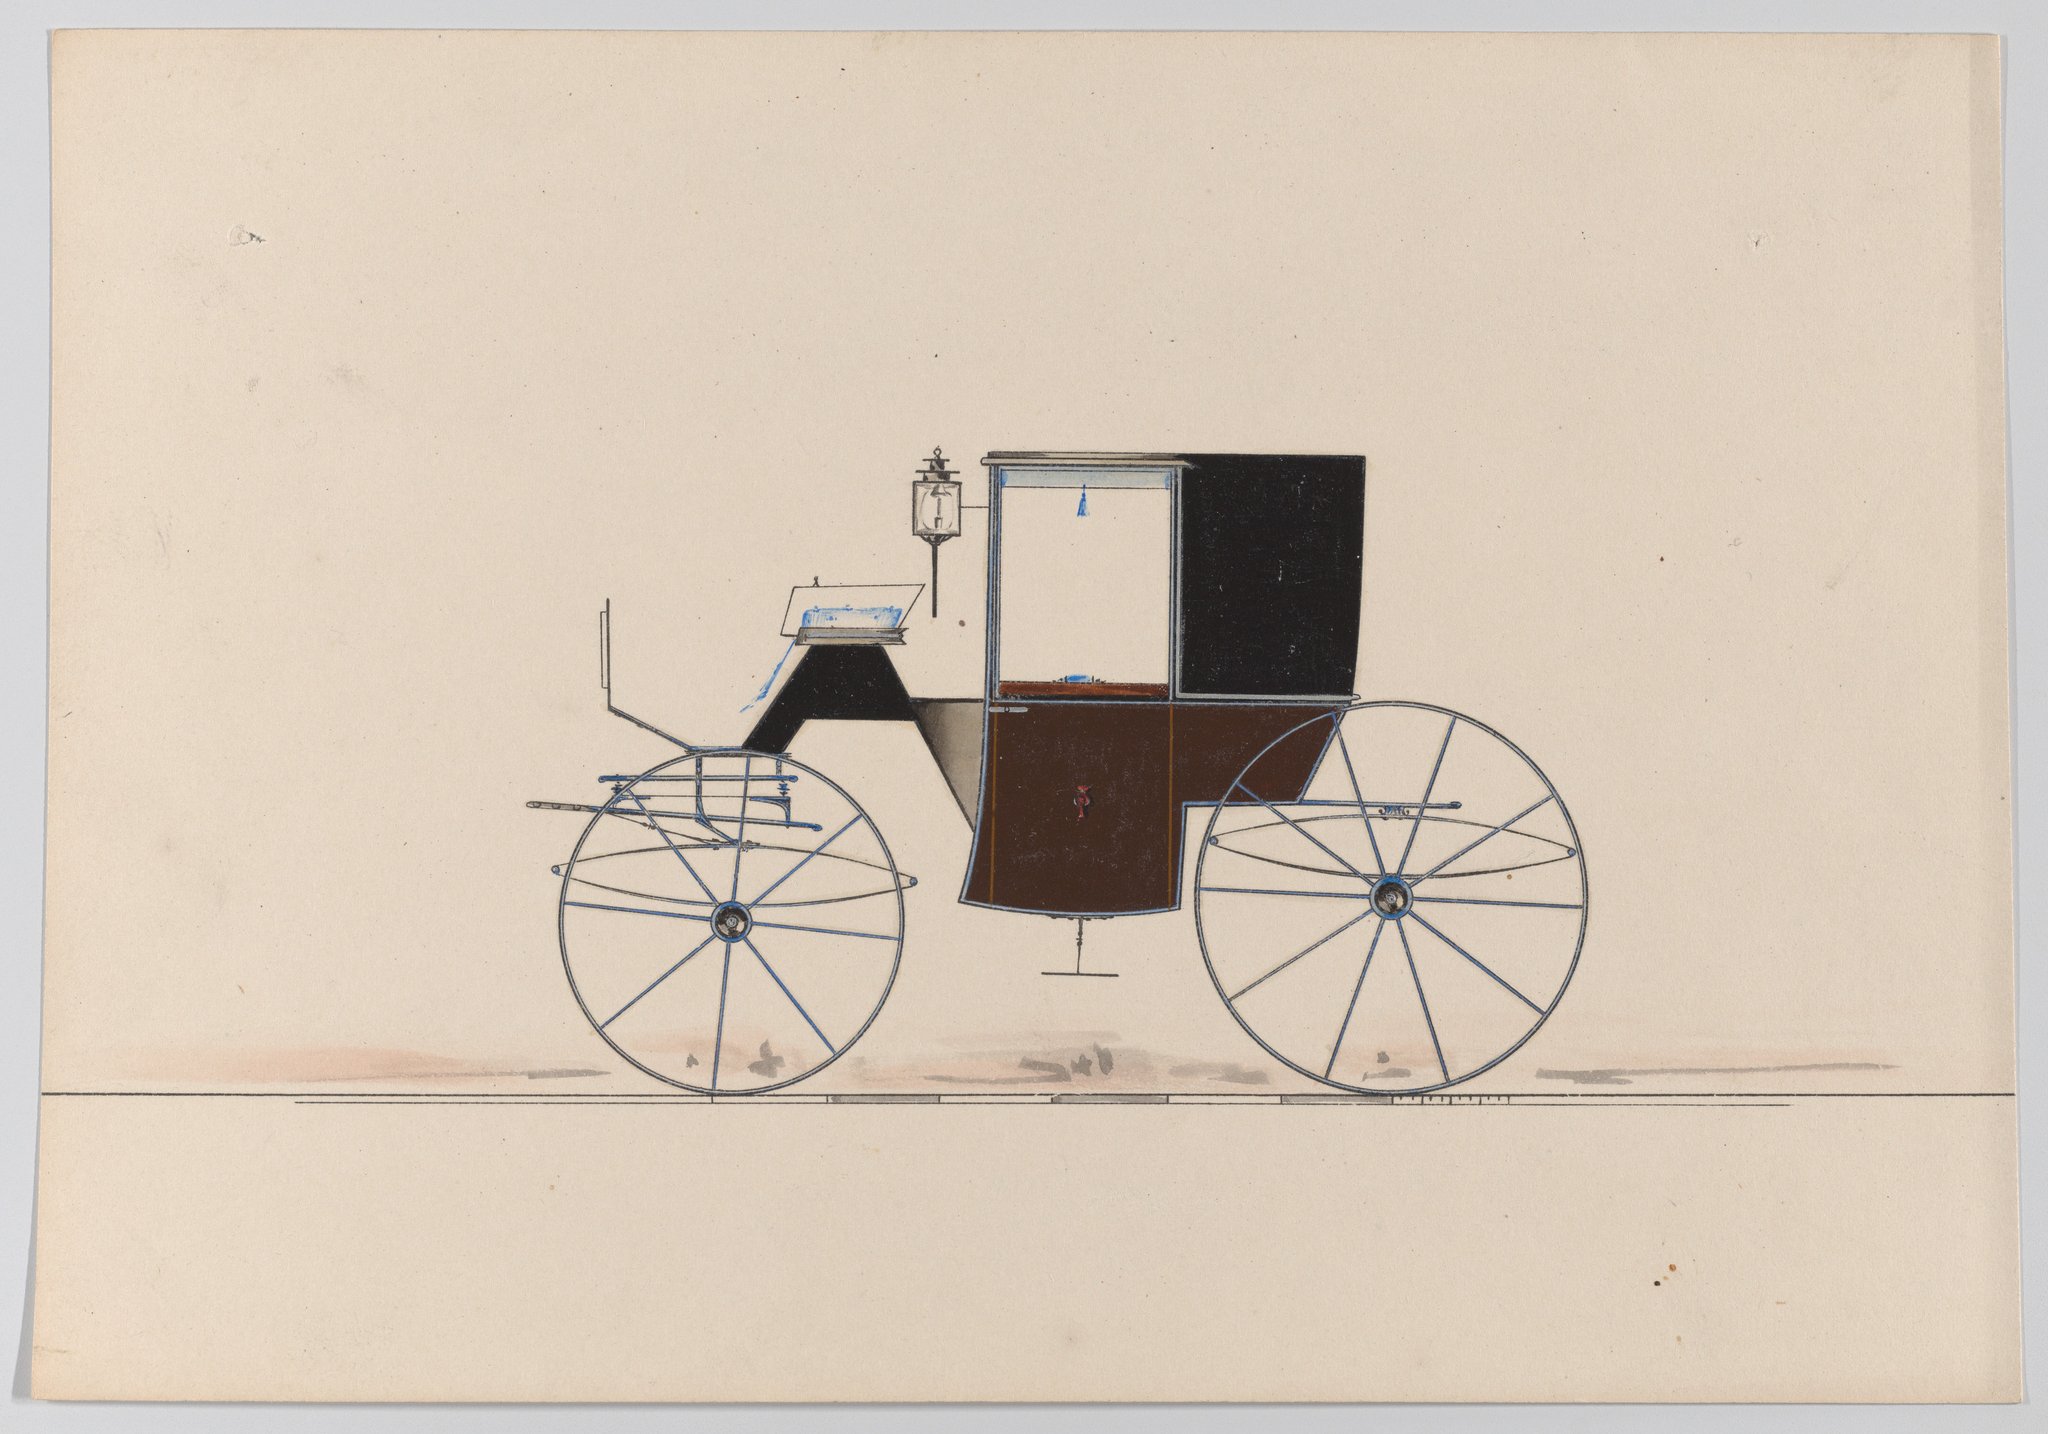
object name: drawing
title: Design for Brougham (unnumbered)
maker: brewster & co.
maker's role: manufacturer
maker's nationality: american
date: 1870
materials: gouache, gum arabic, ink, watercolor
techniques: pen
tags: carriages